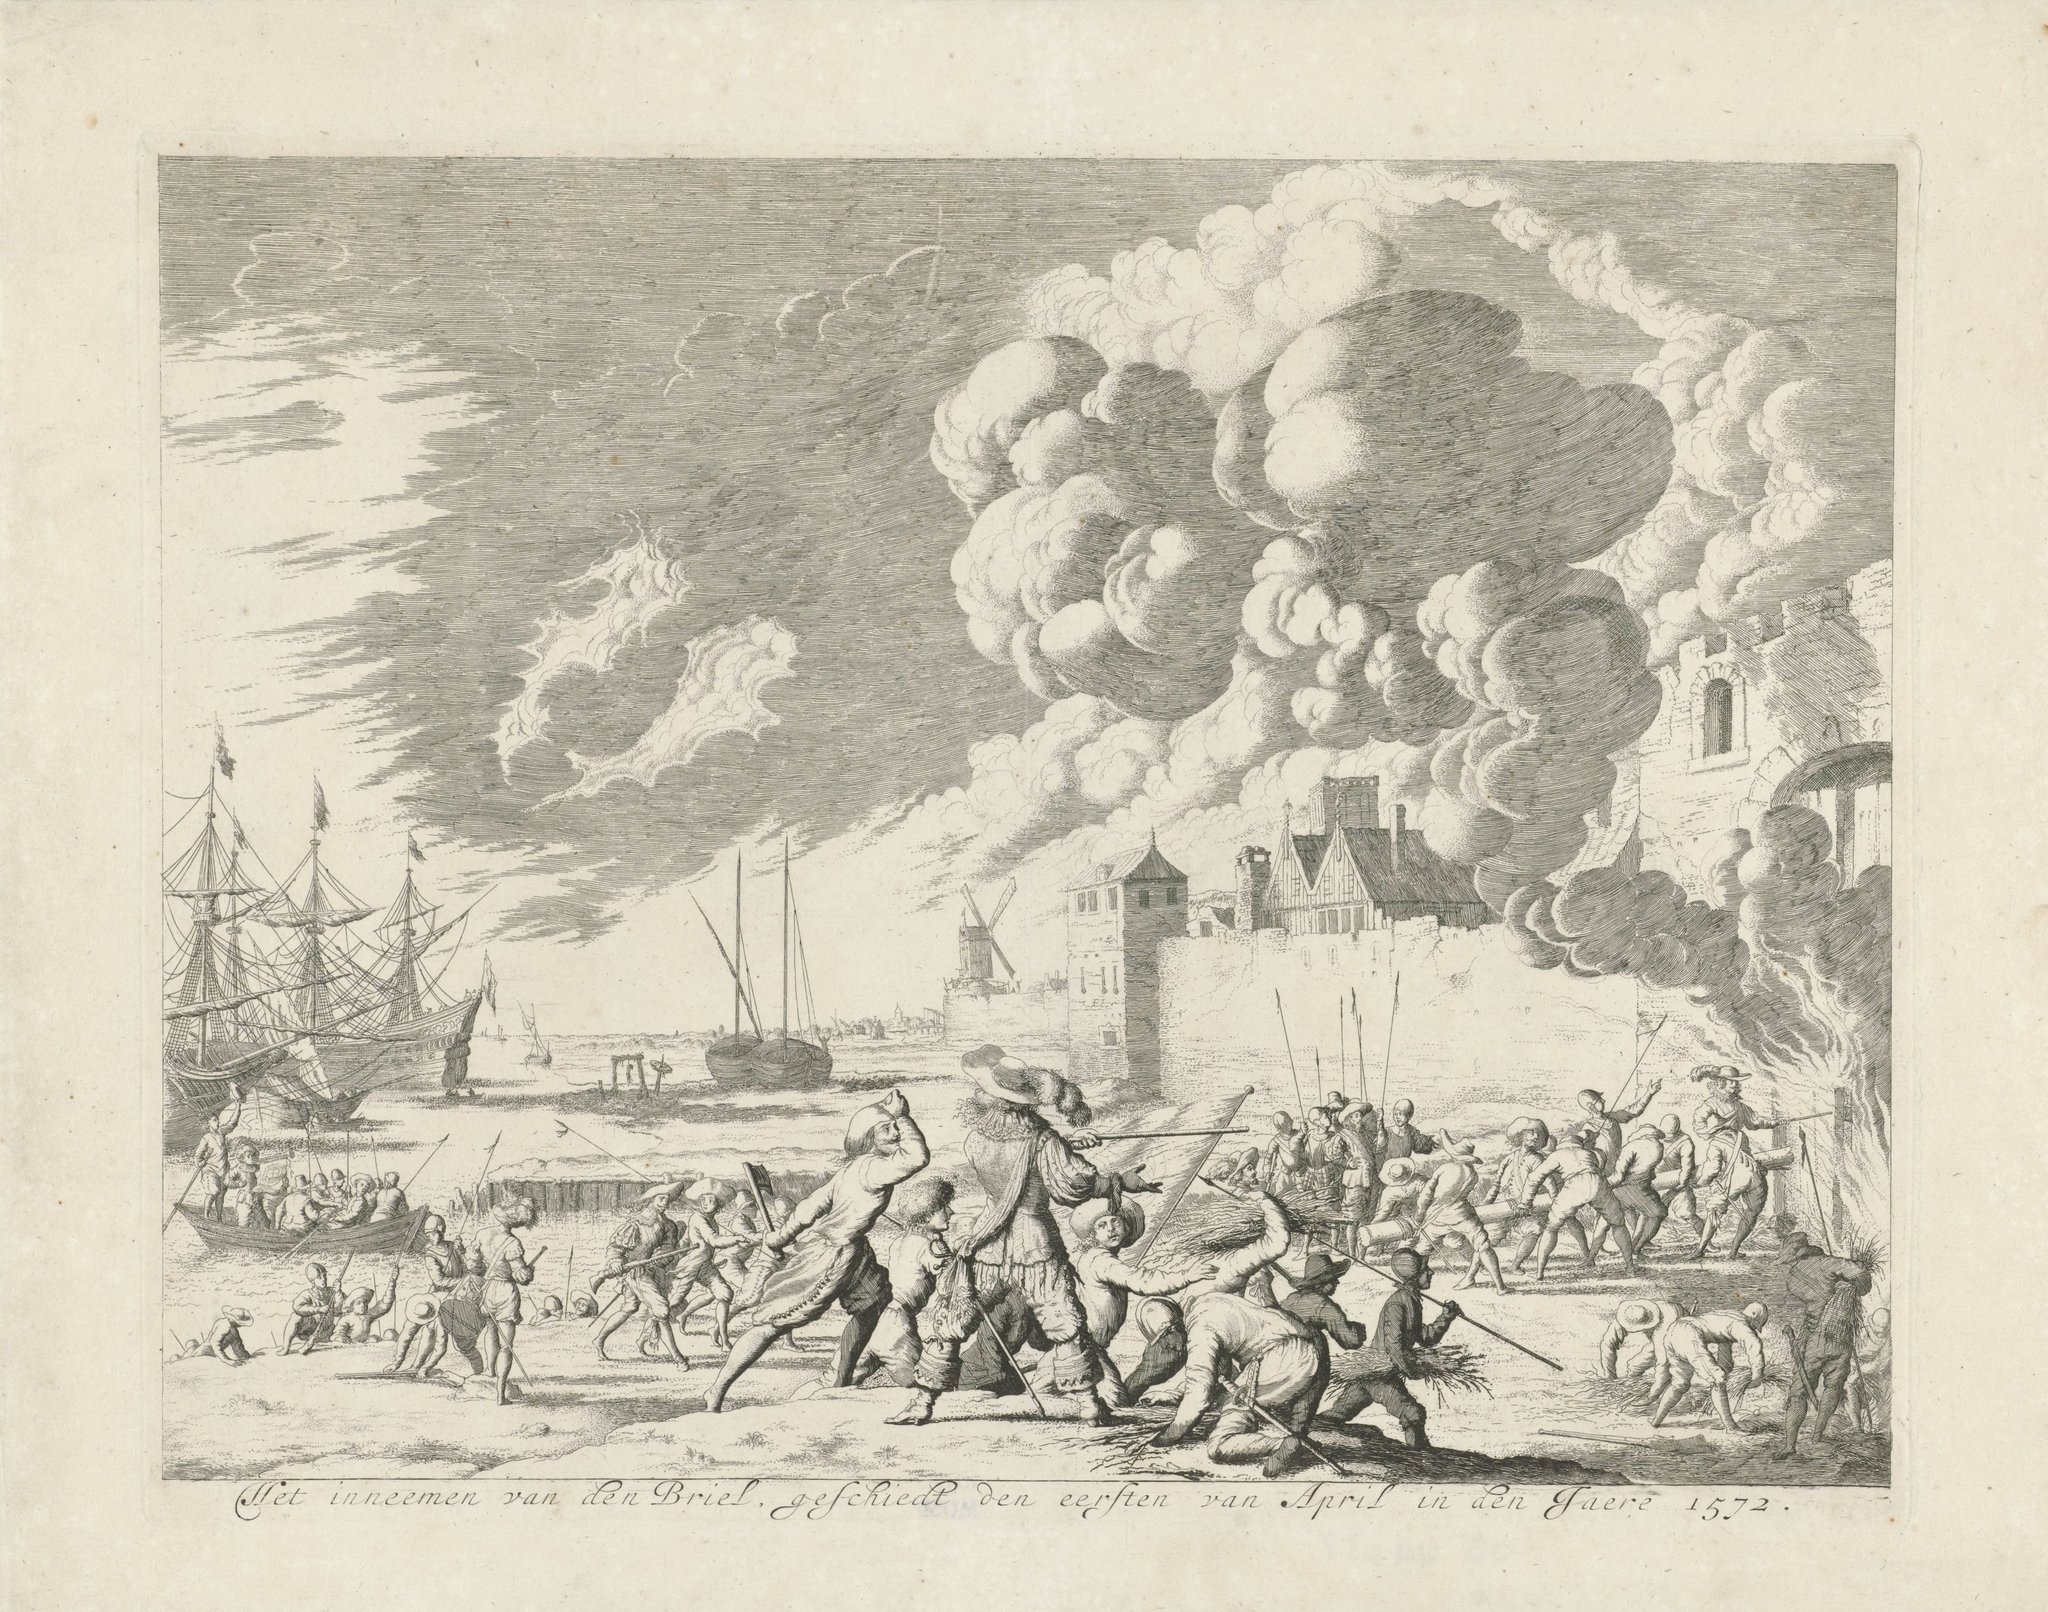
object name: print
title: Inname van Den Briel, 1572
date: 1679-1684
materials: paper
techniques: etching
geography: amsterdam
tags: capture of city (after the siege), brielle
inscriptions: collector's mark: Lugt 2166, collector's mark: Lugt 240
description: Illustratie gebruikt in: Bor Christiaansz, Pieter. Oorsprongk, begin, en vervolgh der Nederlandsche oorlogen, 4 delen. Amsterdam: weduwe Joannes van Someren, Abraham Wolfgang, Hendrick en Dirk Boom, 1679-1684, dl. I, p. 366.